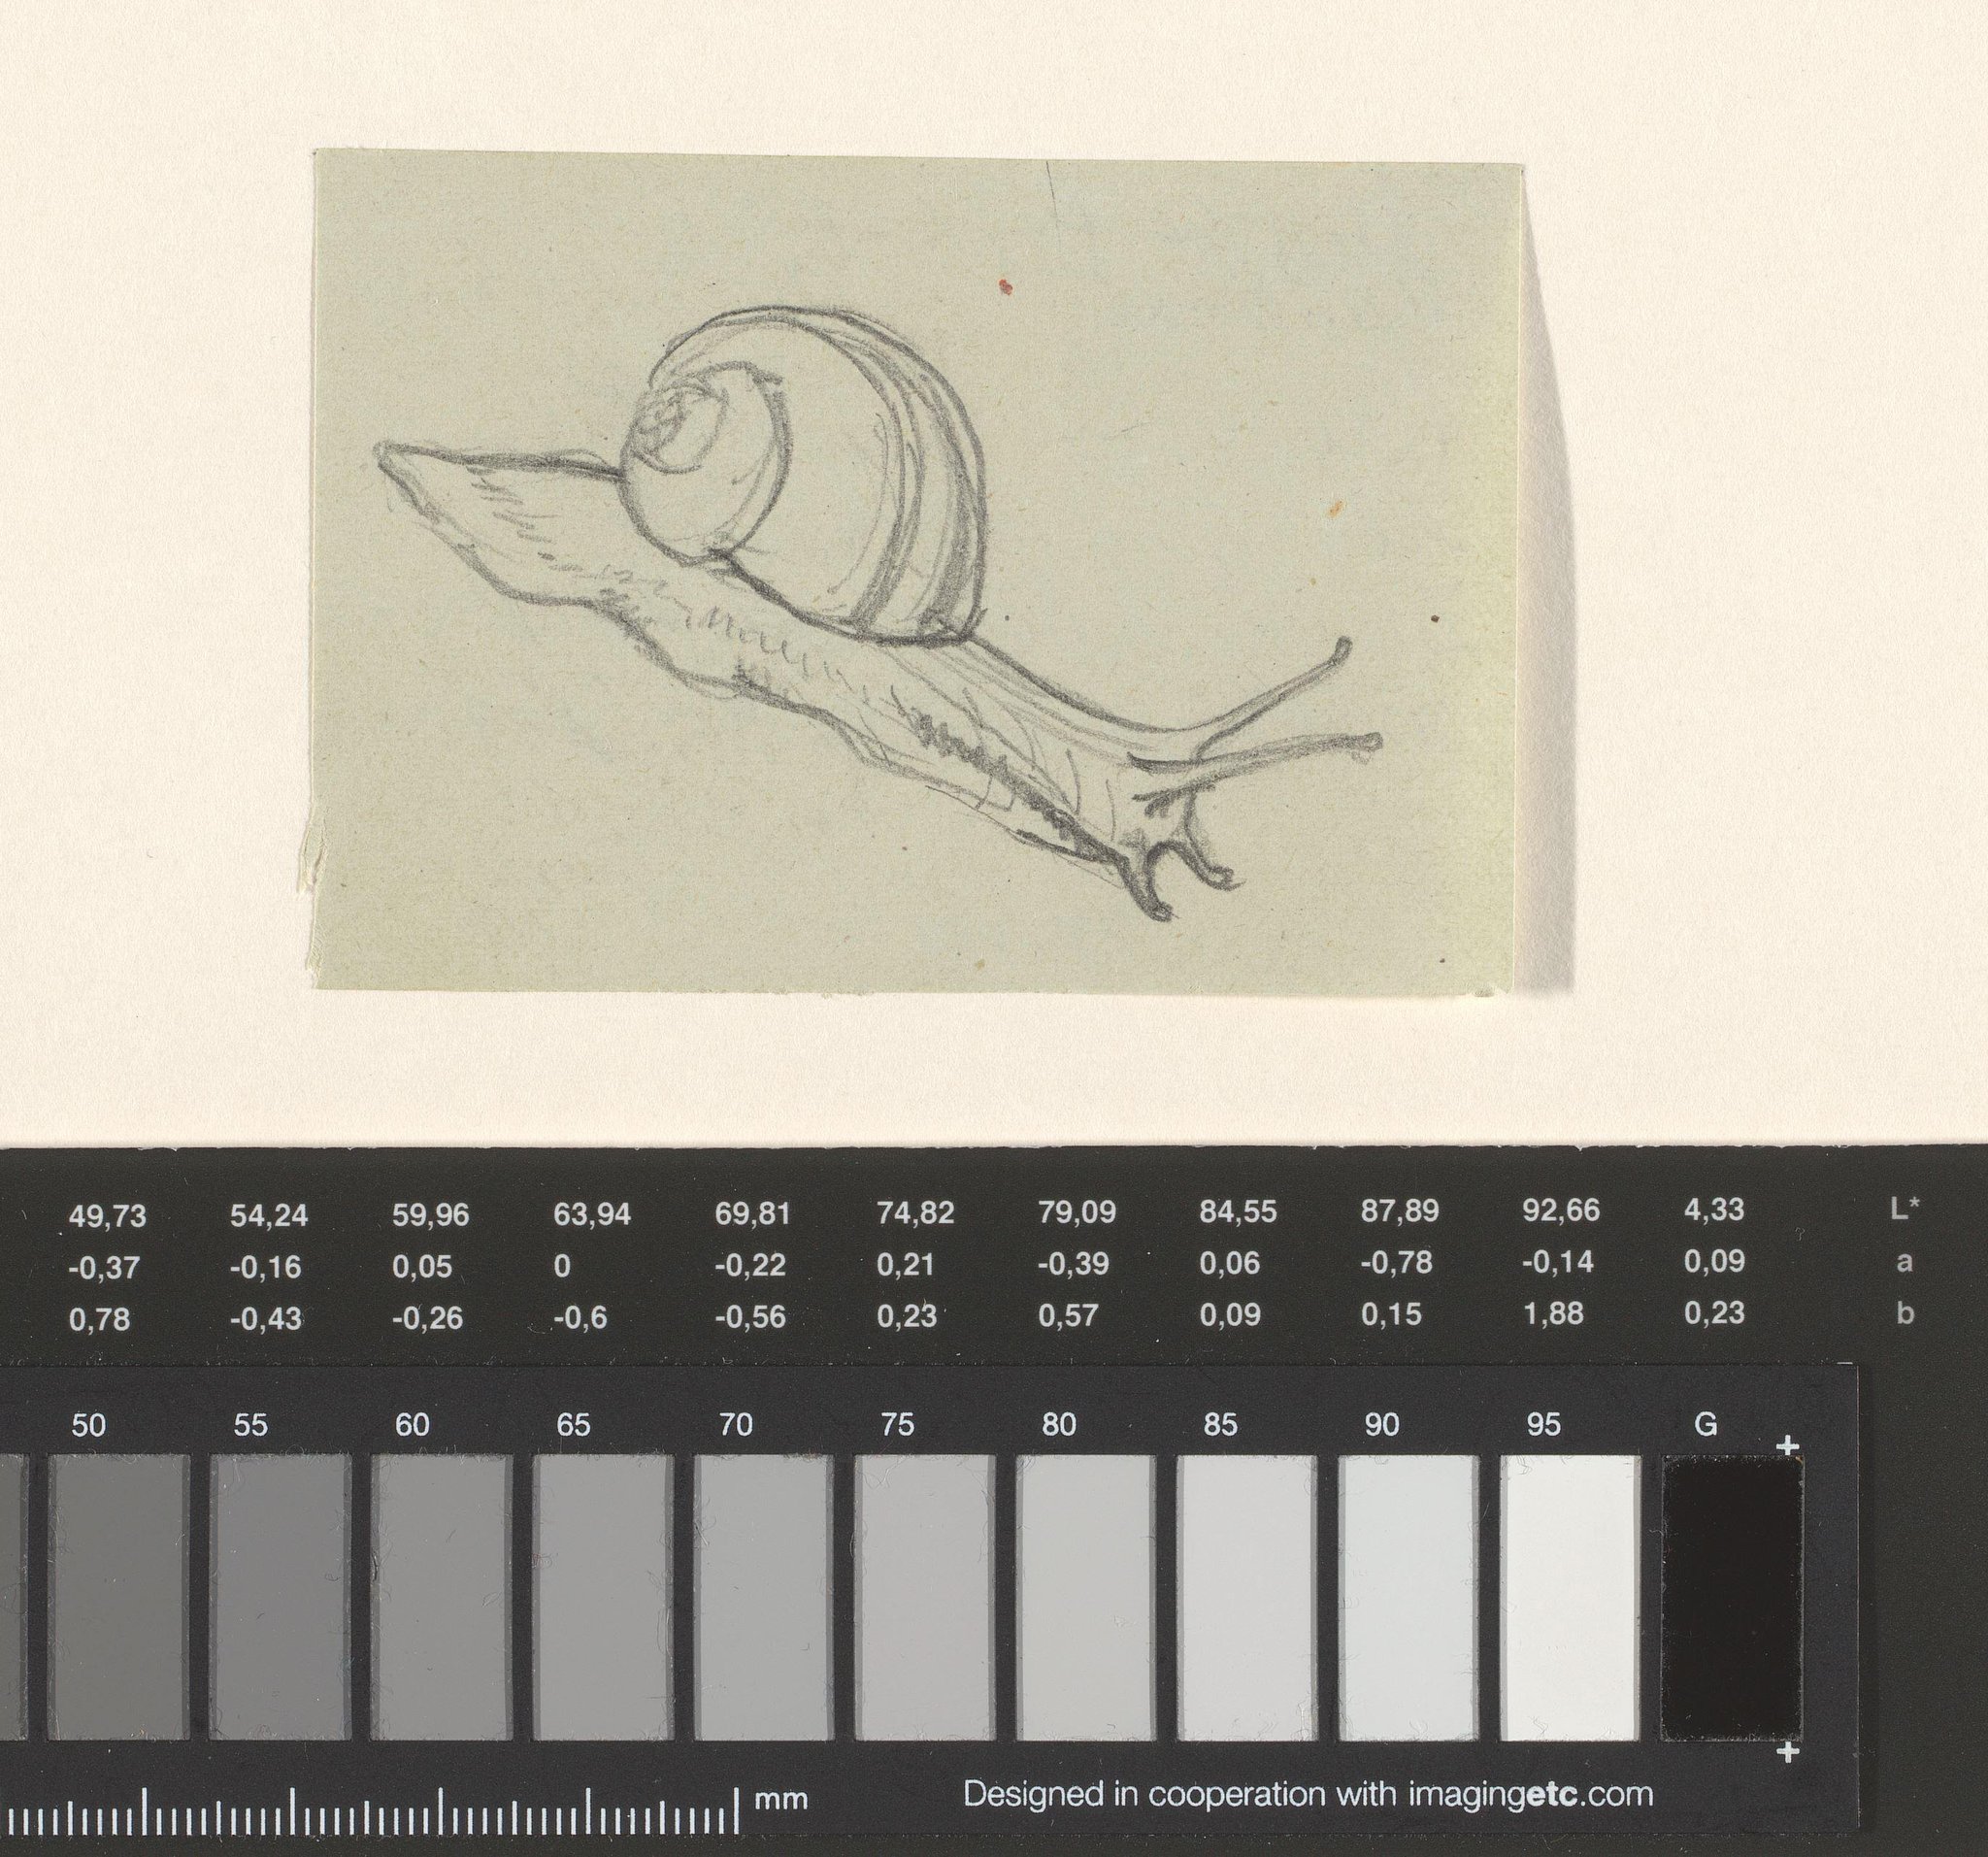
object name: drawing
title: Slak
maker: julie de graag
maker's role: draughtsman, print maker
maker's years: 1877-1924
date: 1887-1924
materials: paper, pencil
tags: molluscs: snail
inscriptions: annotation